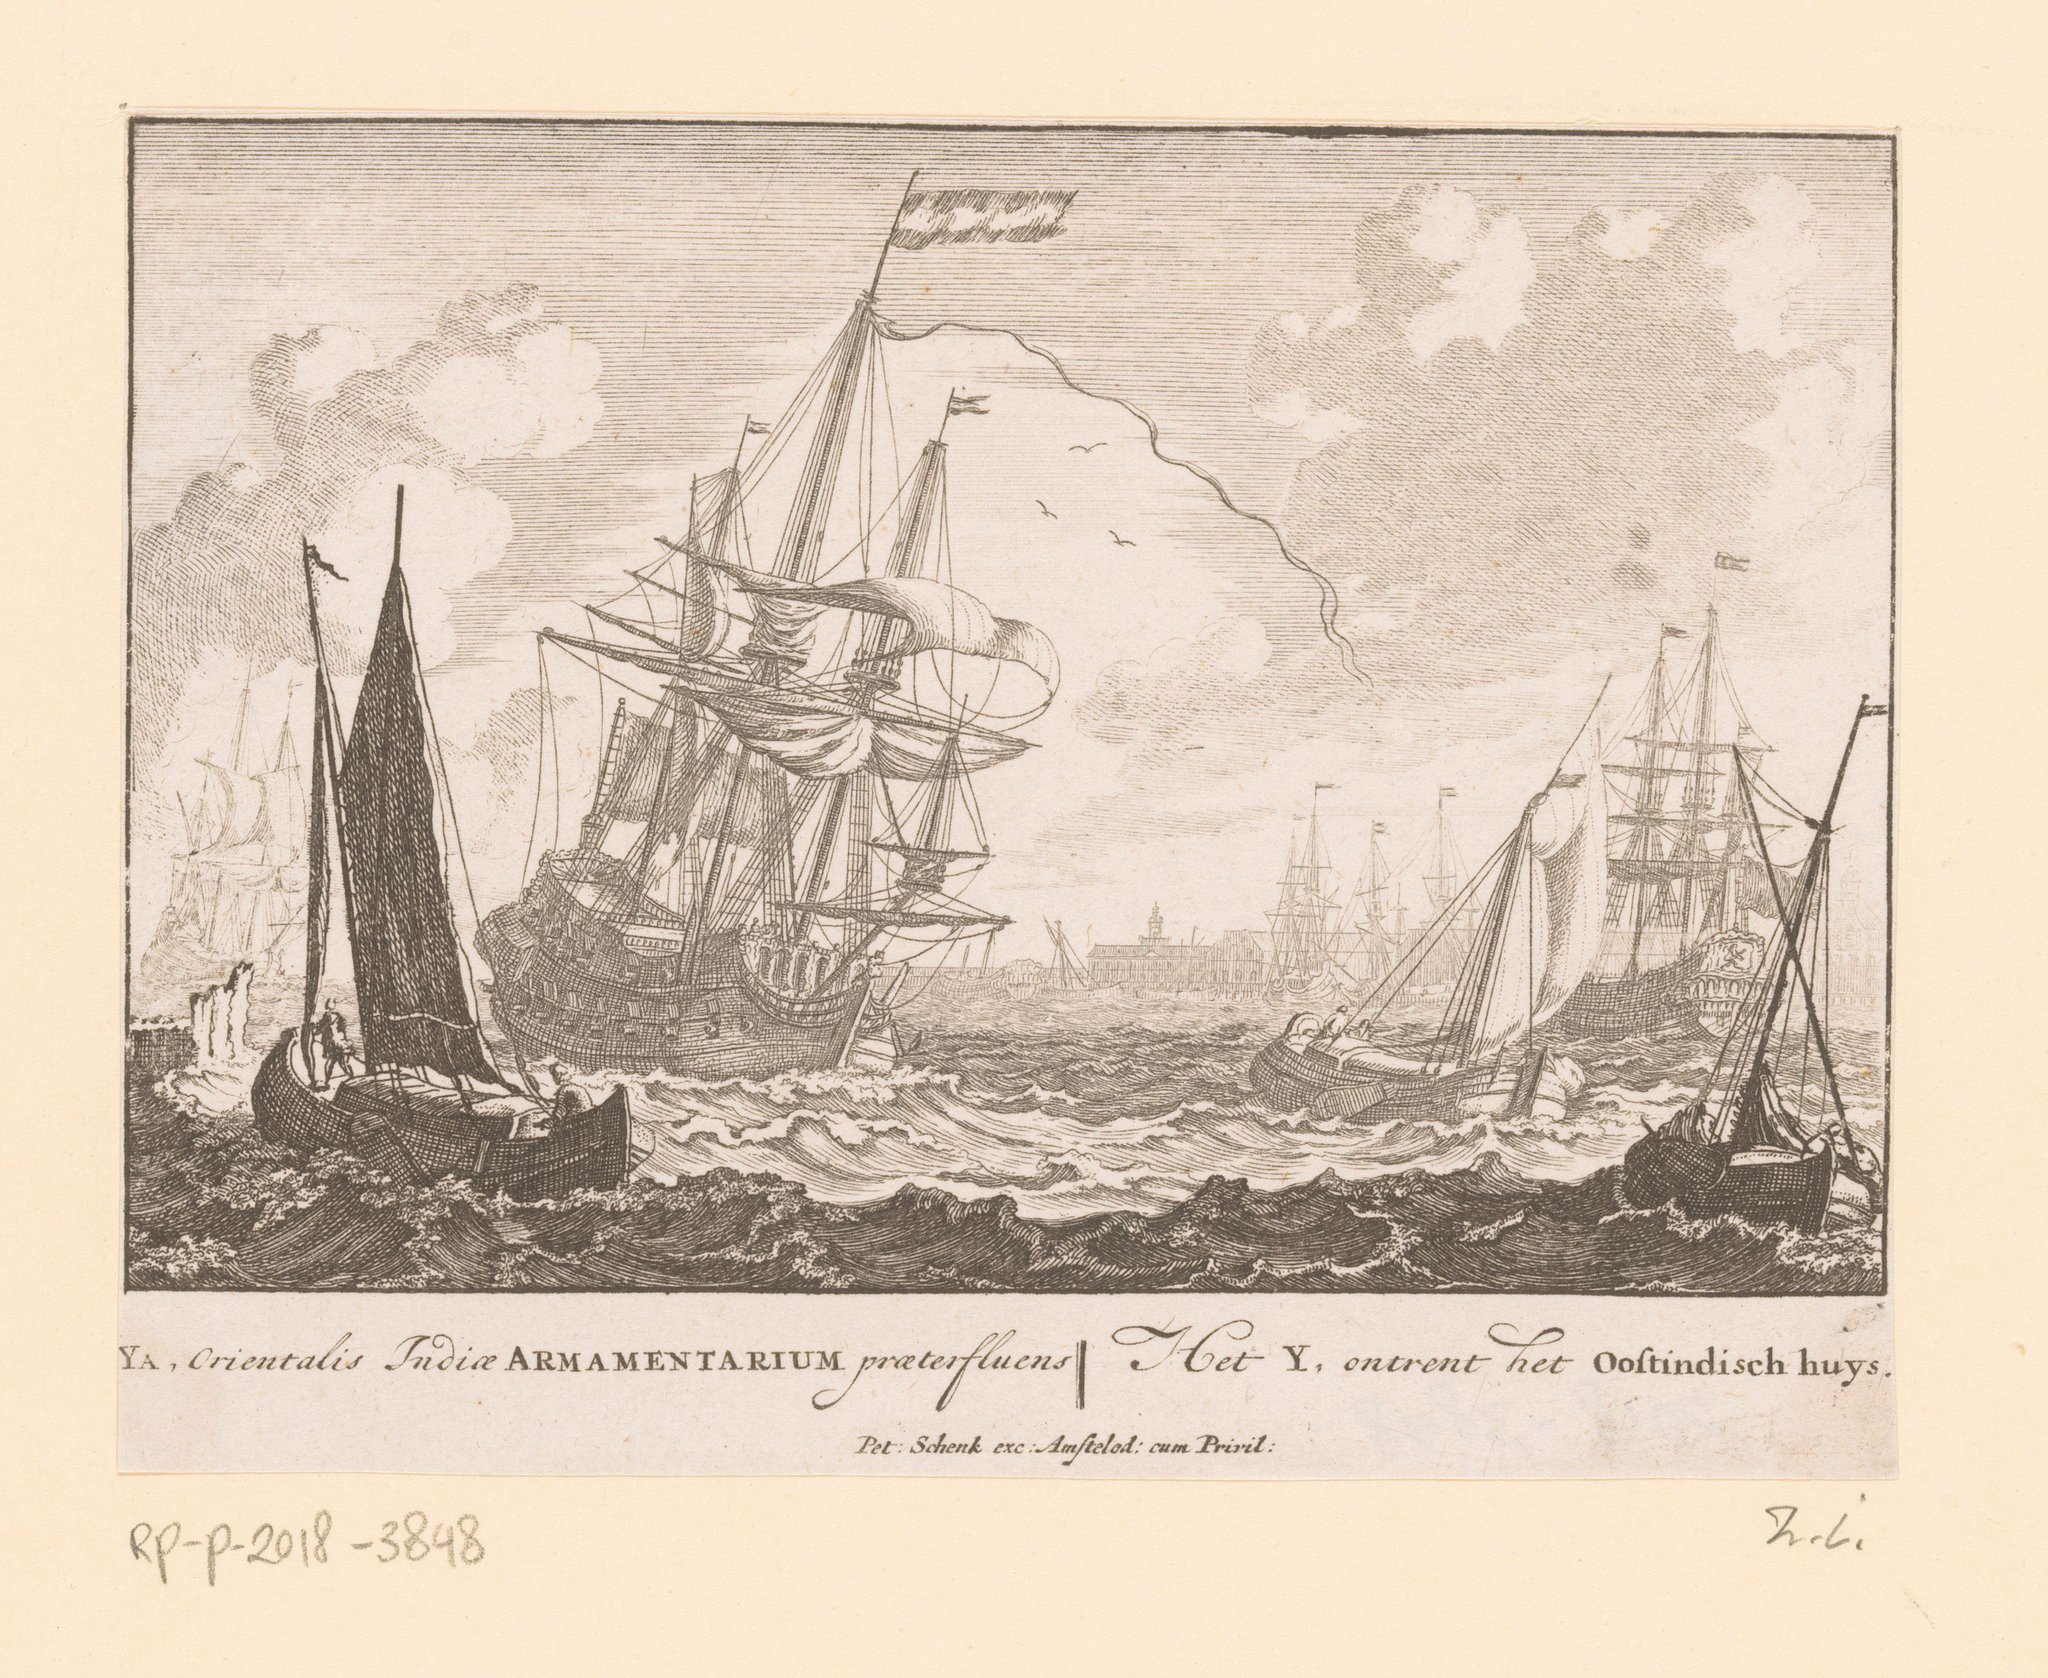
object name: print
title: Ya, Orientalis Indiae Armamentarium praeterfluens / Het Y, ontrent het Oostindisch huys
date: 1694-1697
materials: paper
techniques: etching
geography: amsterdam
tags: harbour, city-view, and landscape with man-made constructions, ships (in general) - cc - more than one ship, amsterdam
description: Prent mogelijk uit: Admirandorum Quadruplex Spectaculum. Amsterdam: Pieter Schenk (I), [1694-1697]. In Hollstein vermeld bij een serie van 100 prenten over Amsterdam, maar de prenten die in Hollstein worden genoemd zijn groter. De prent is een latere staat van RP-P-2018-3837, met het nummer 56.